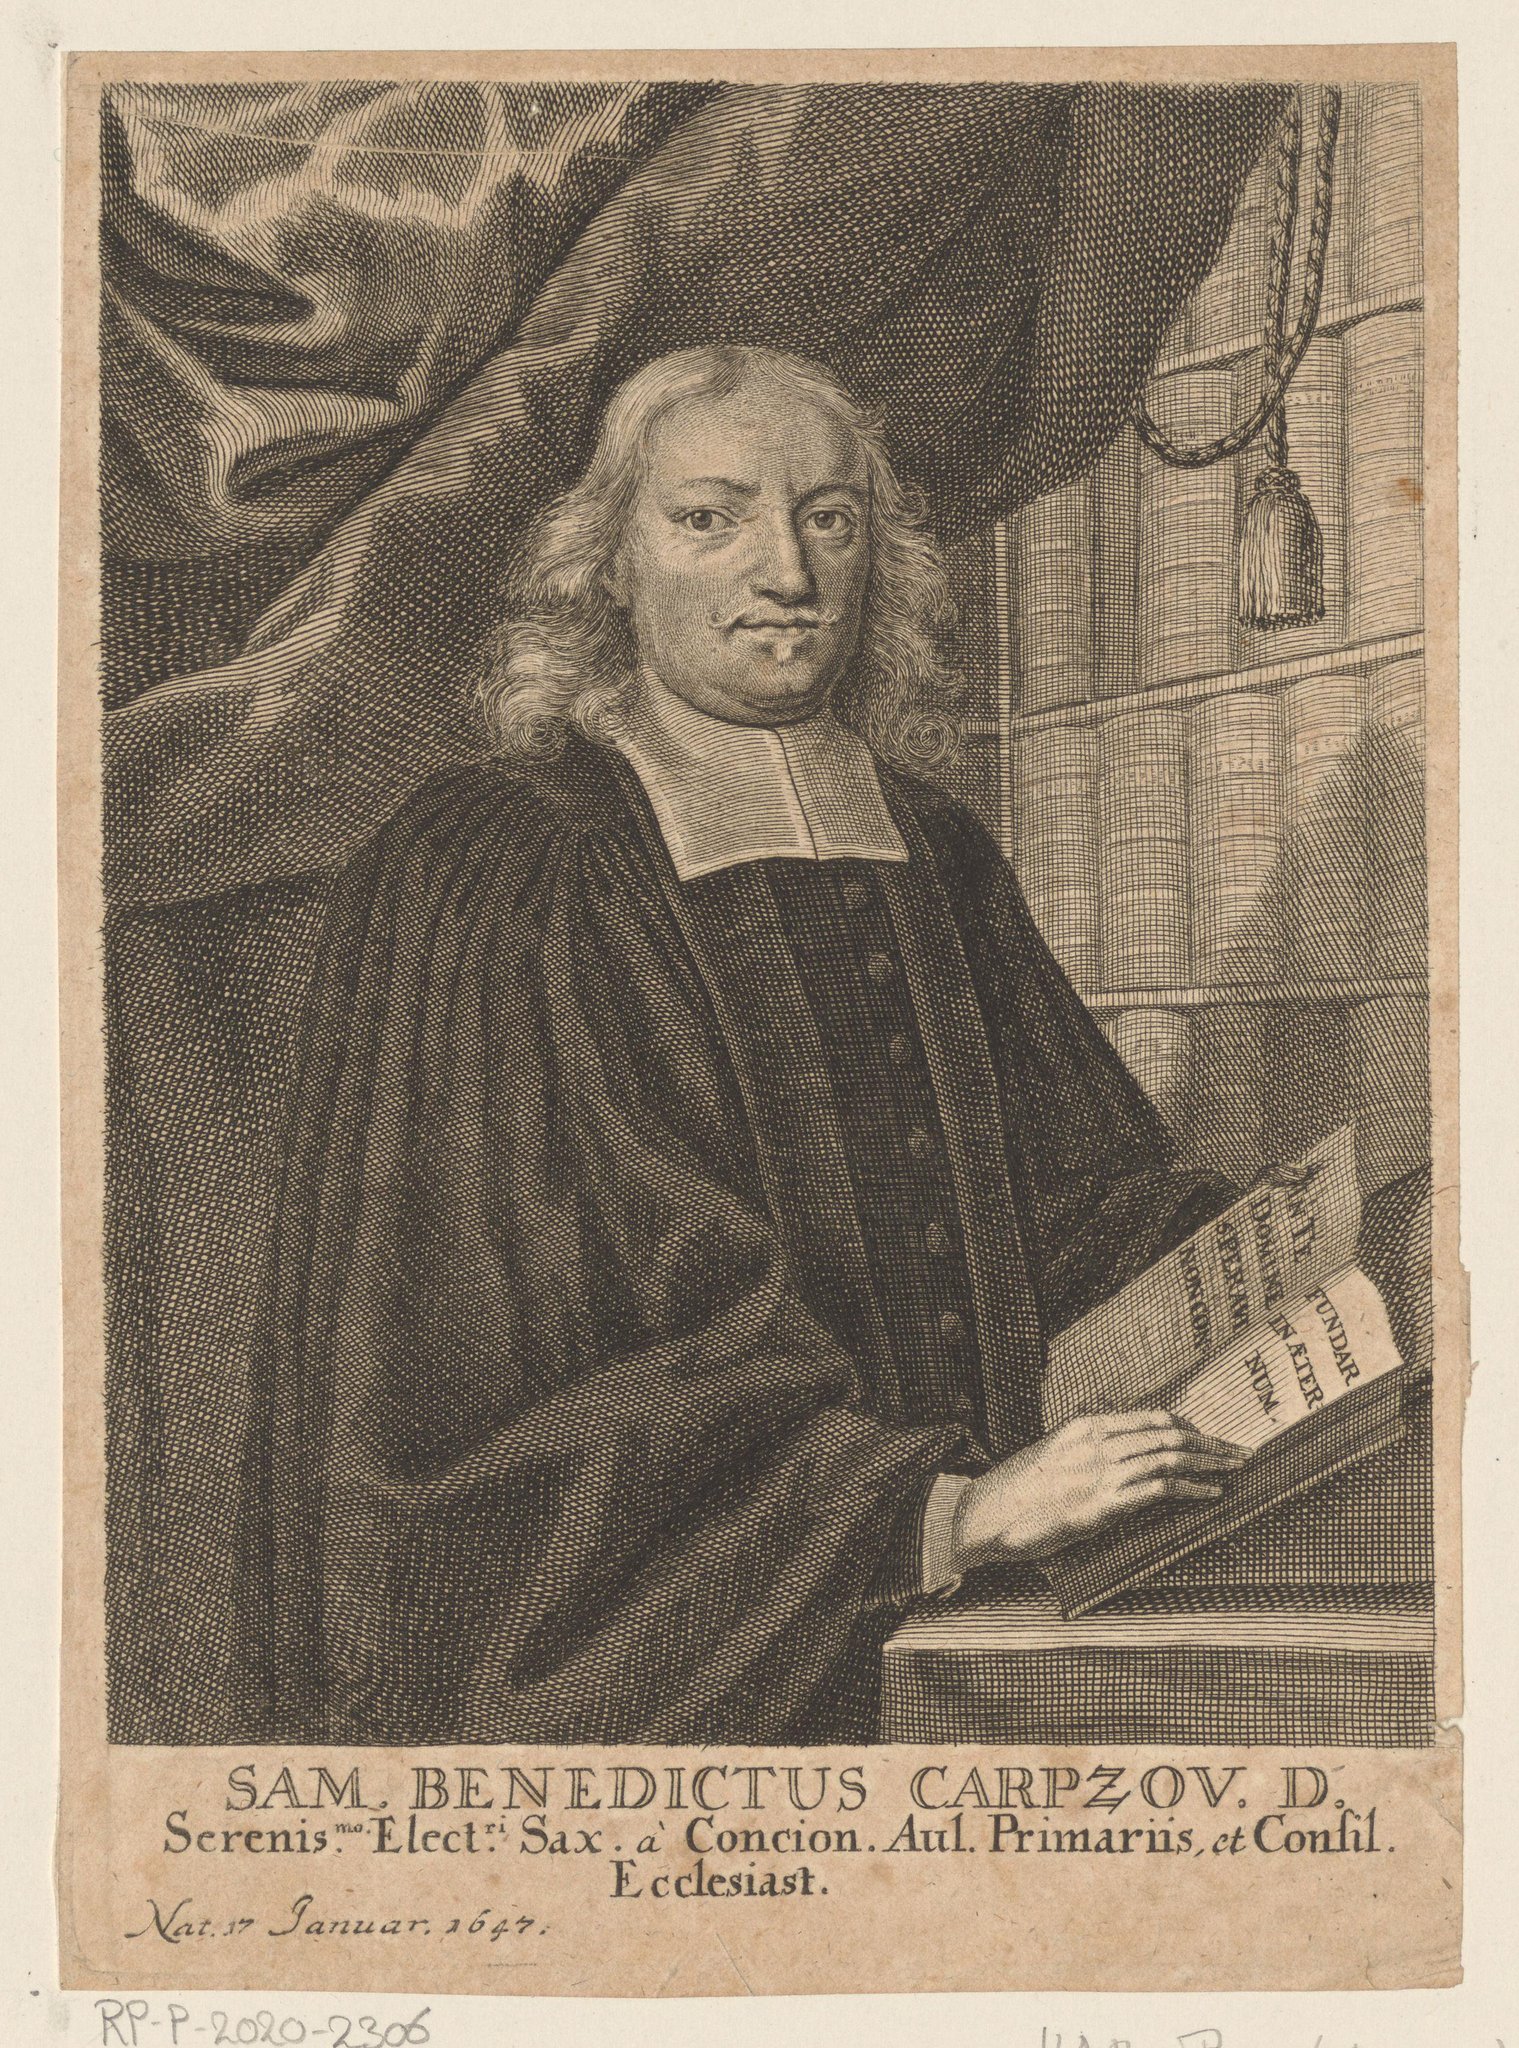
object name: print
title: Portret van Samuel Benedikt Carpzov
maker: Anonymous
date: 1667-1707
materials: paper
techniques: engraving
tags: samuel benedikt carpzov, historical persons